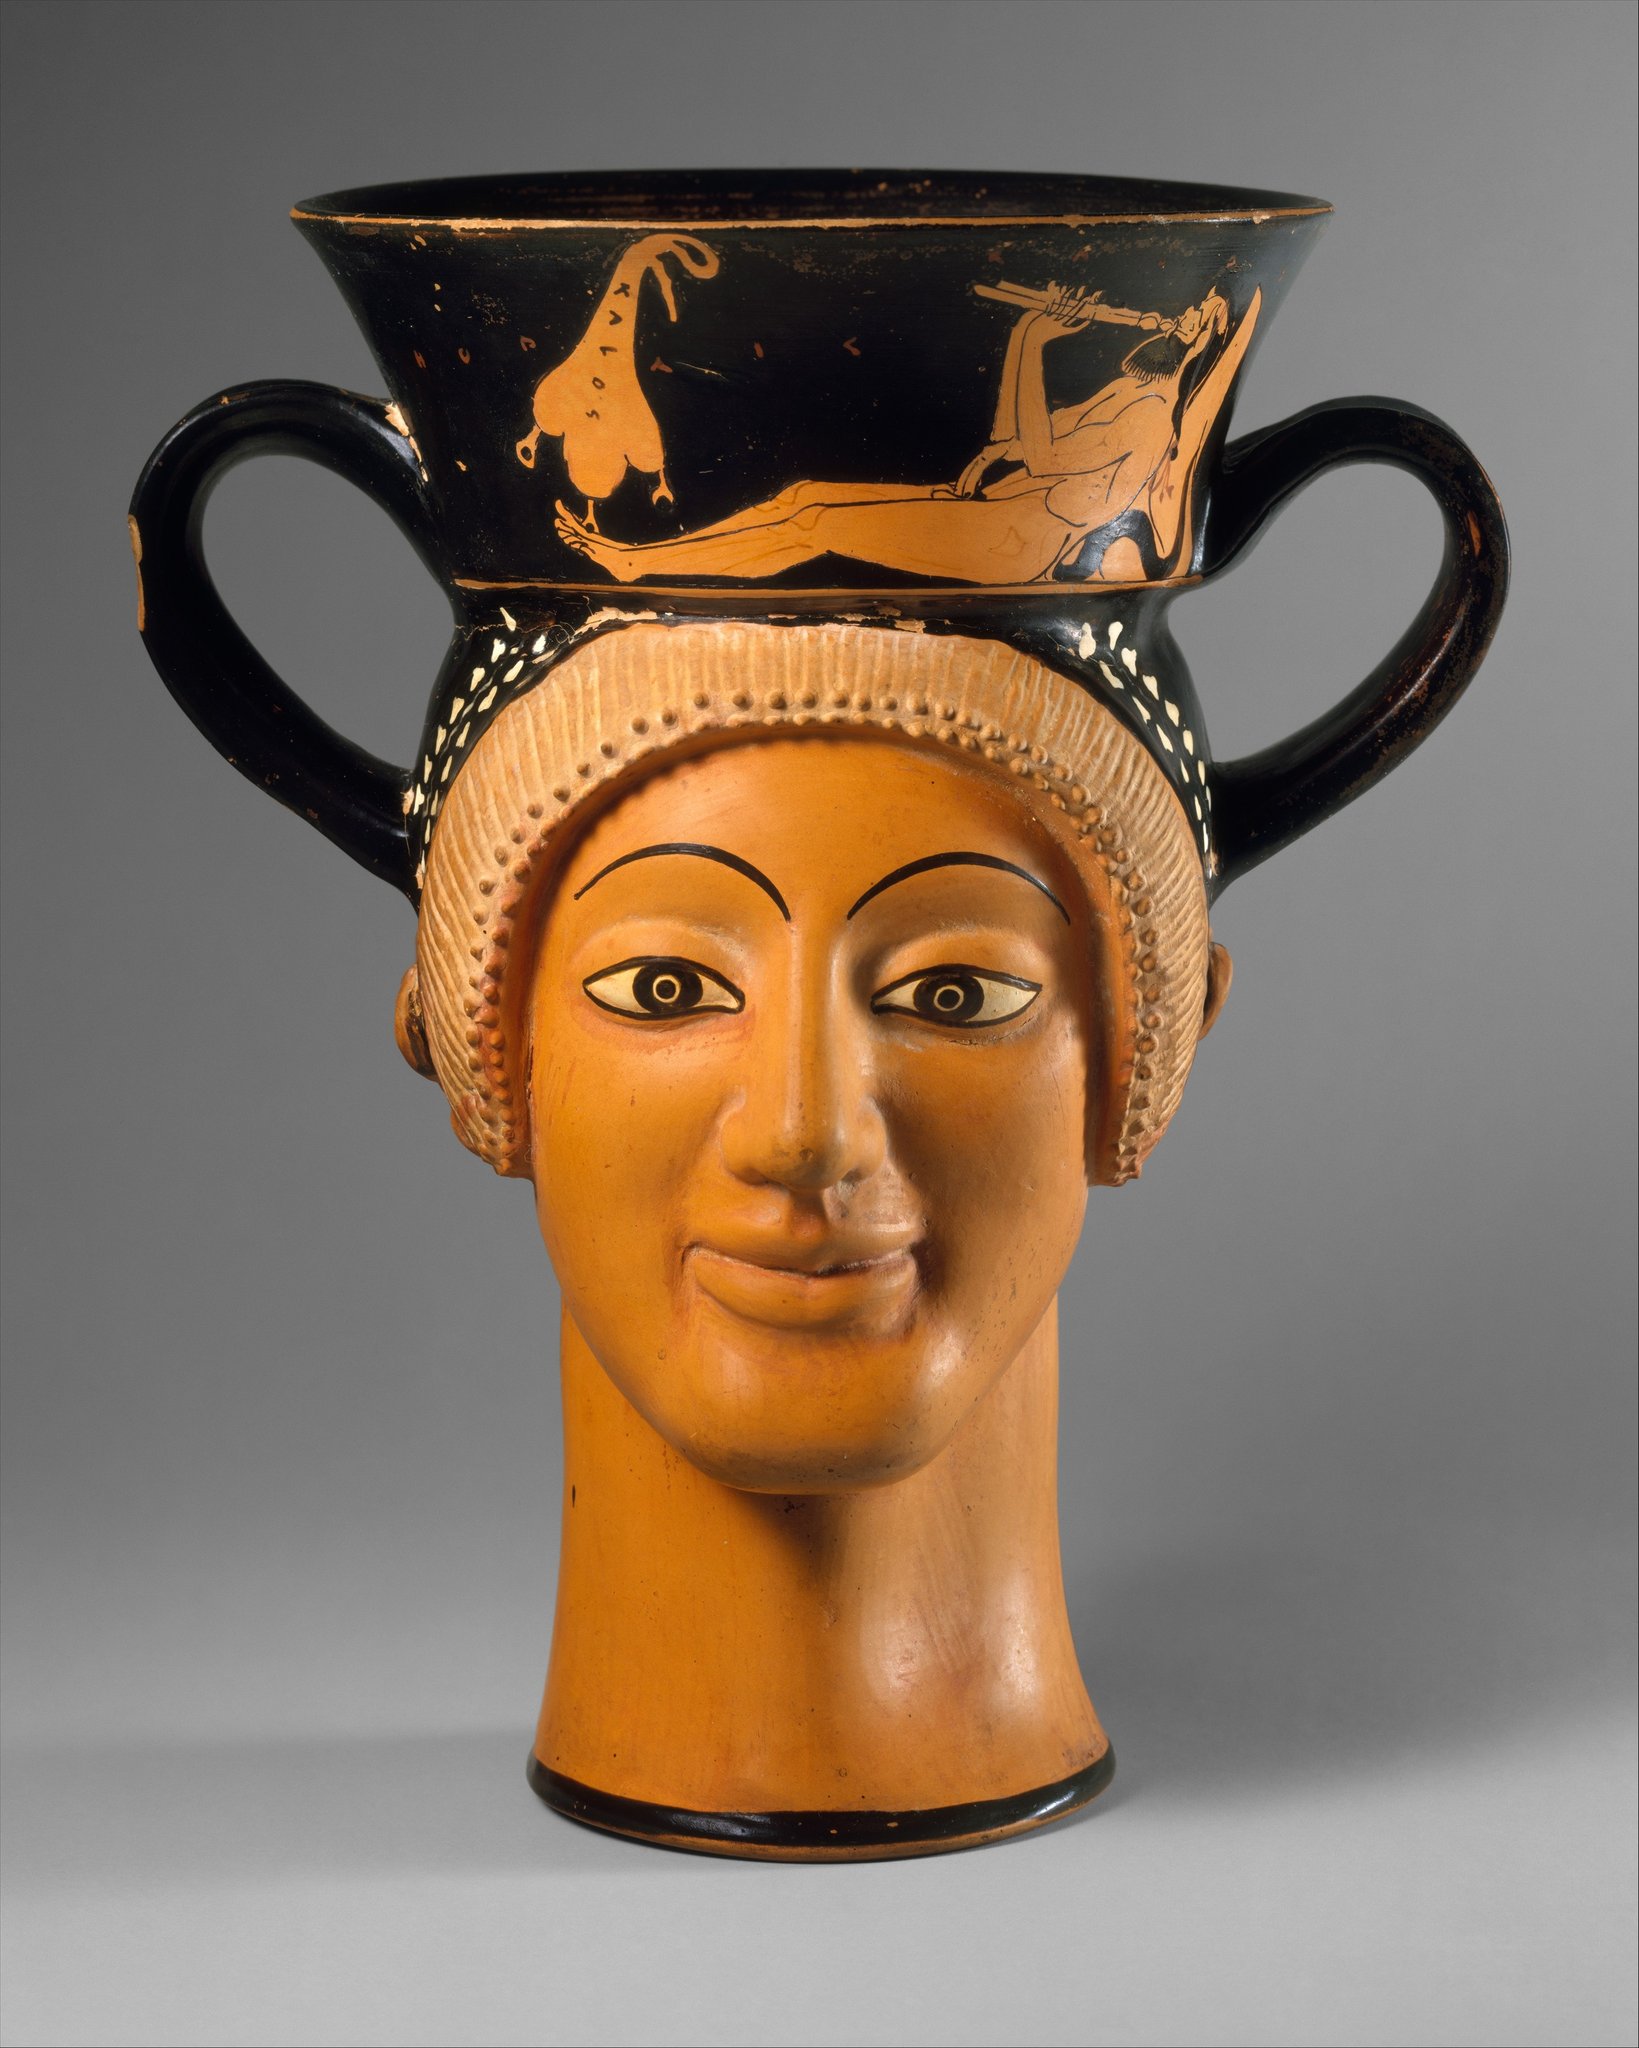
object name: kantharos in the form of two female head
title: Terracotta kantharos (drinking cup with high handles): two female heads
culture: greek, attic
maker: brygos painter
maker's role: artist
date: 490-480 BCE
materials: terracotta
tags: heads,women,music,flutes,satyrs